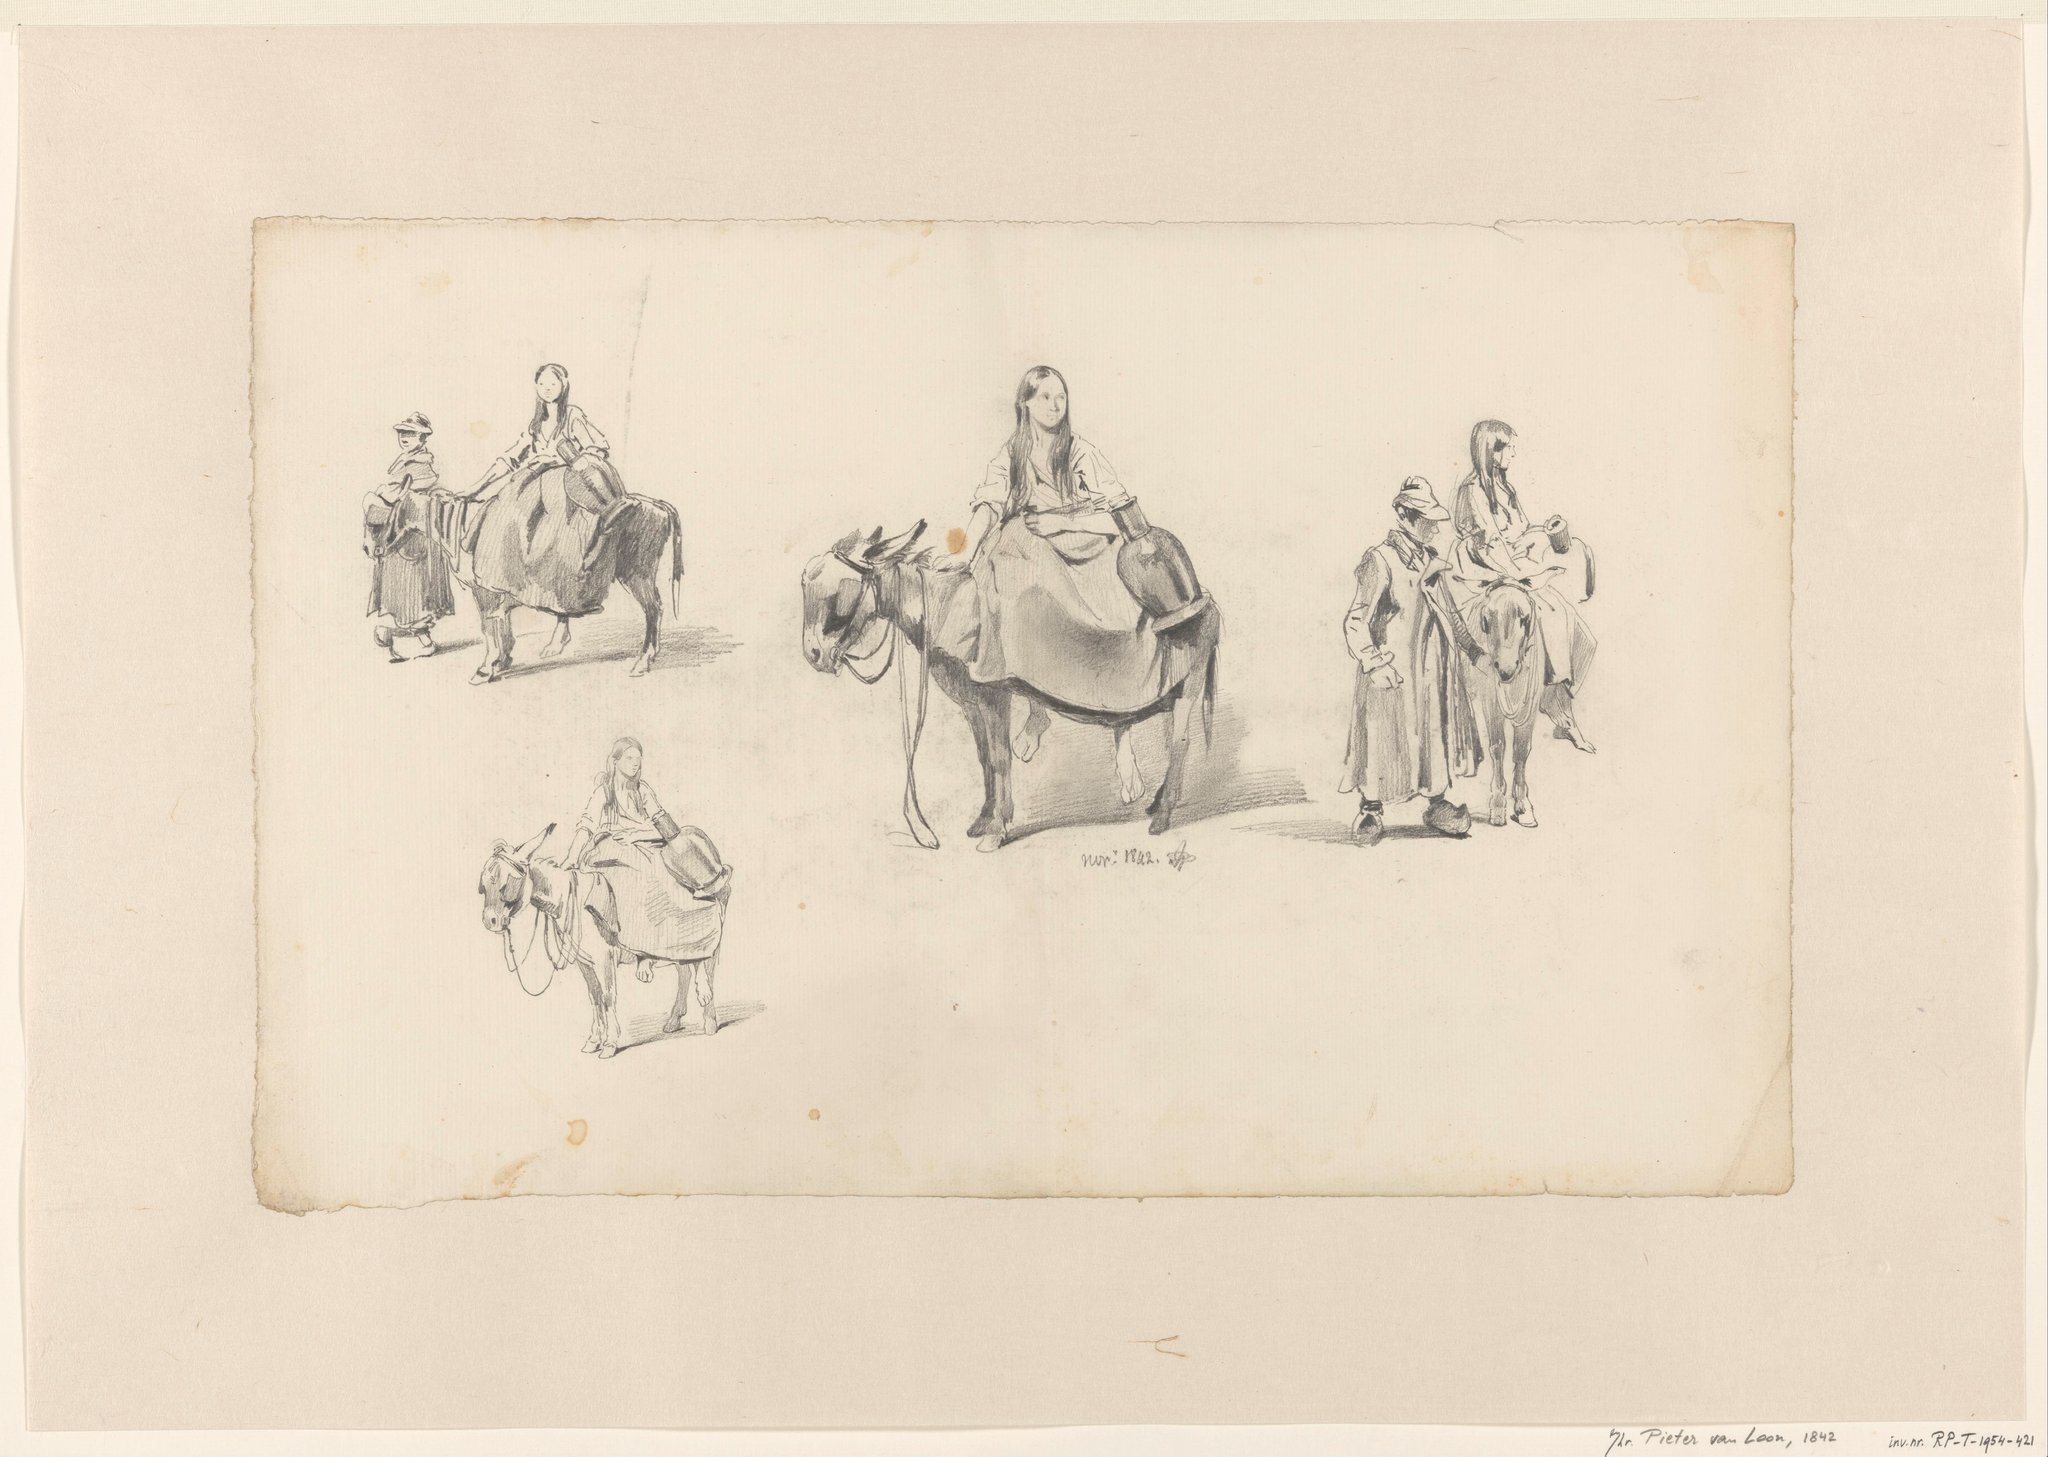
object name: drawing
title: Studies van een vrouw met kruik, rijdend op een ezel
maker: pieter van loon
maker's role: draughtsman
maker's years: 1801-1873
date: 1842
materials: paper, pencil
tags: riding a horse, ass, or mule; rider, horseman